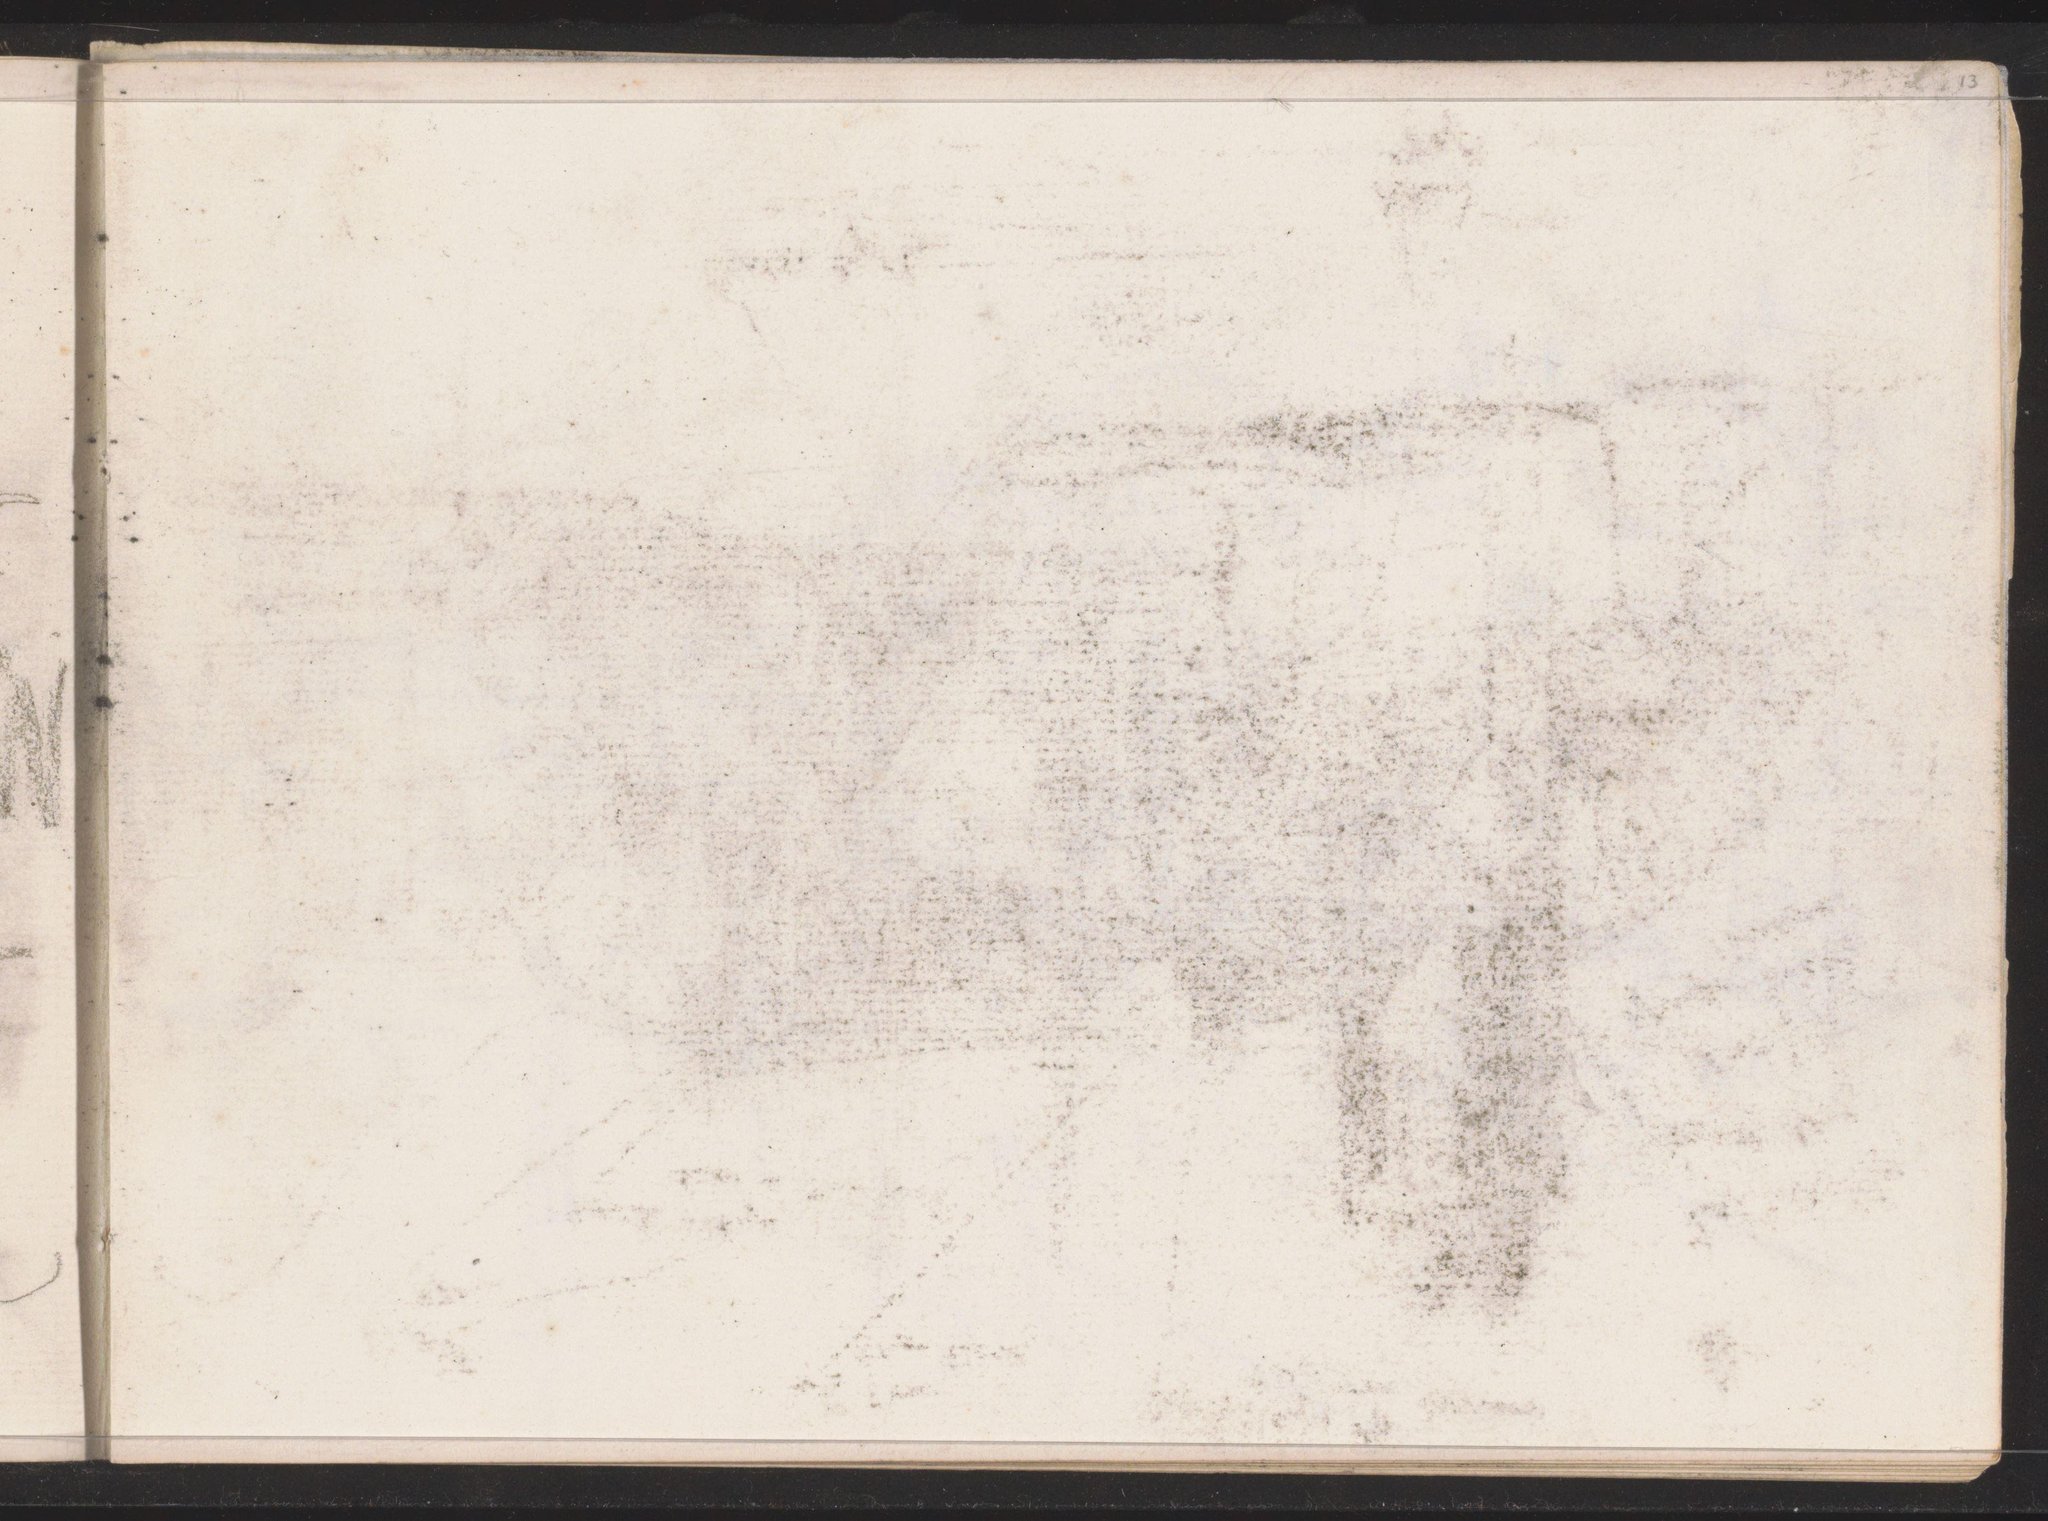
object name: sketchbook leaf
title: Abklatsch van de krijttekening op pagina 12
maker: willem witsen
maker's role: draughtsman, painter, print maker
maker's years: 1860-1923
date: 1897-1899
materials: paper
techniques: printmaking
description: Pagina 13 uit een schetsboek met 17 bladen.